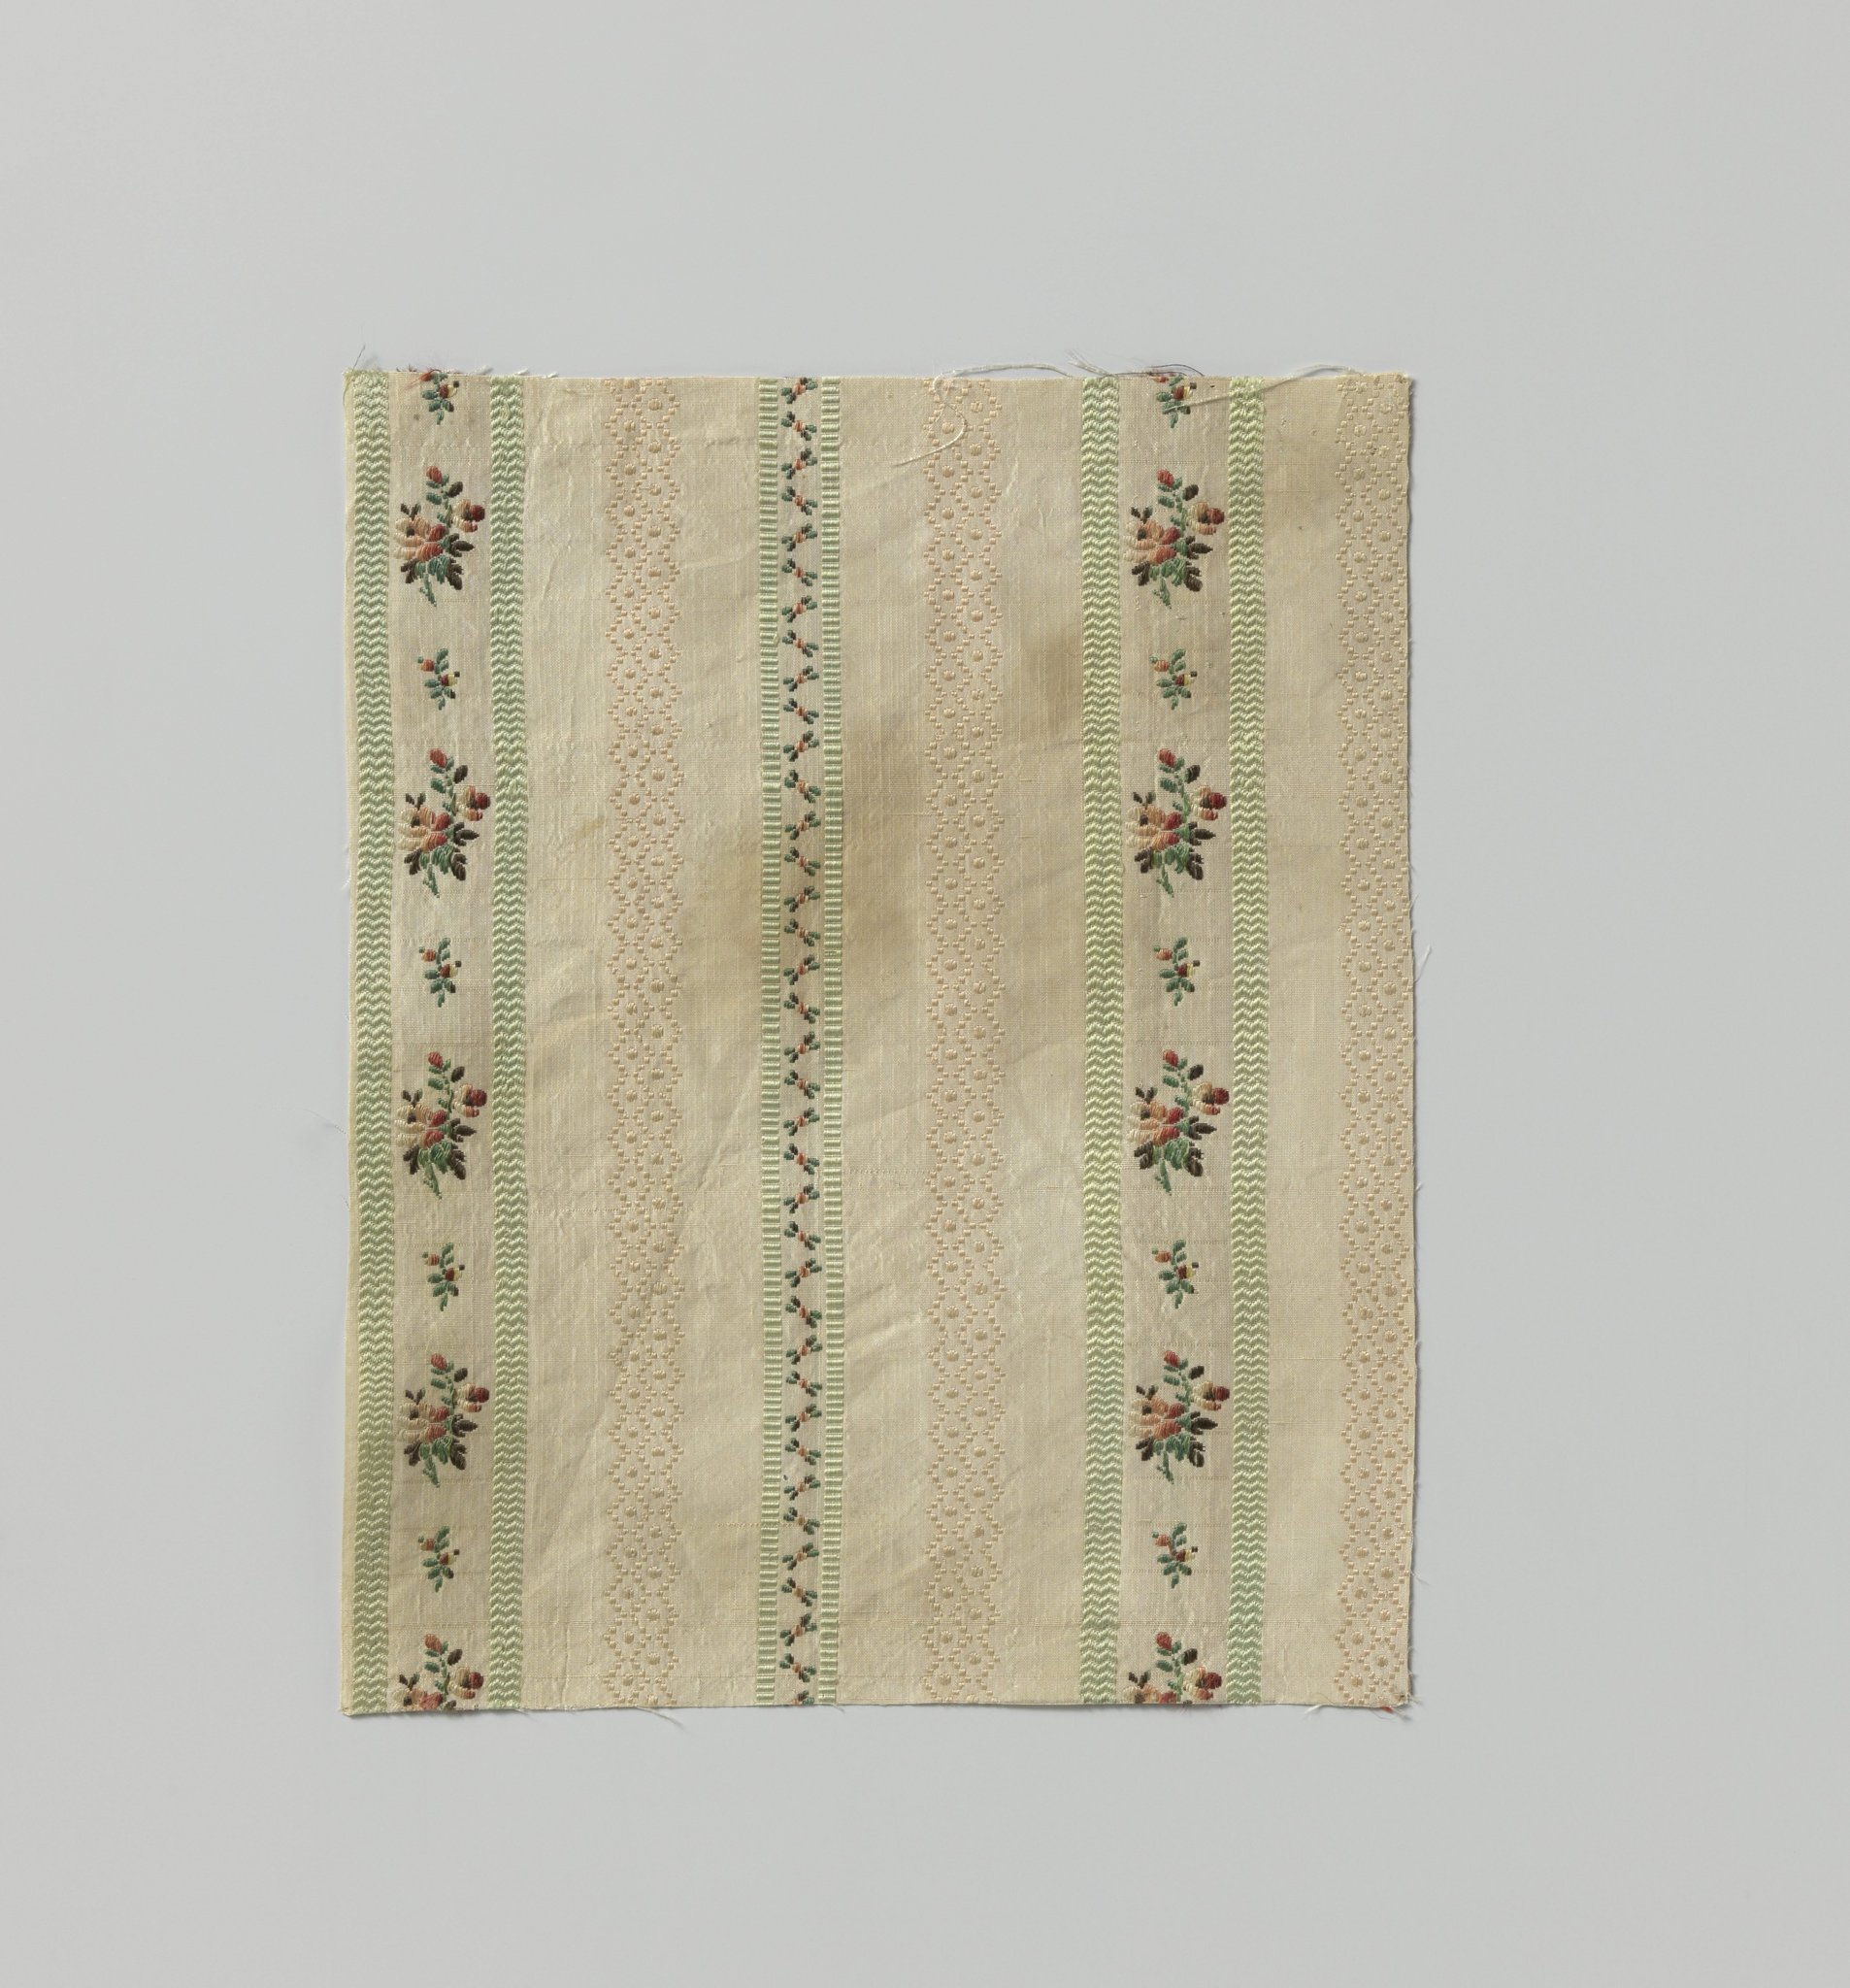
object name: fragment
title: Fragment veelkleurig getreept zijden mexicaine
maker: Anonymous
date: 1750-1800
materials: silk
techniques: mexicaine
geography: france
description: Een fragment van wit, groen en roze gestreepte zijde, waartussen kleine gekleurde boeketten.